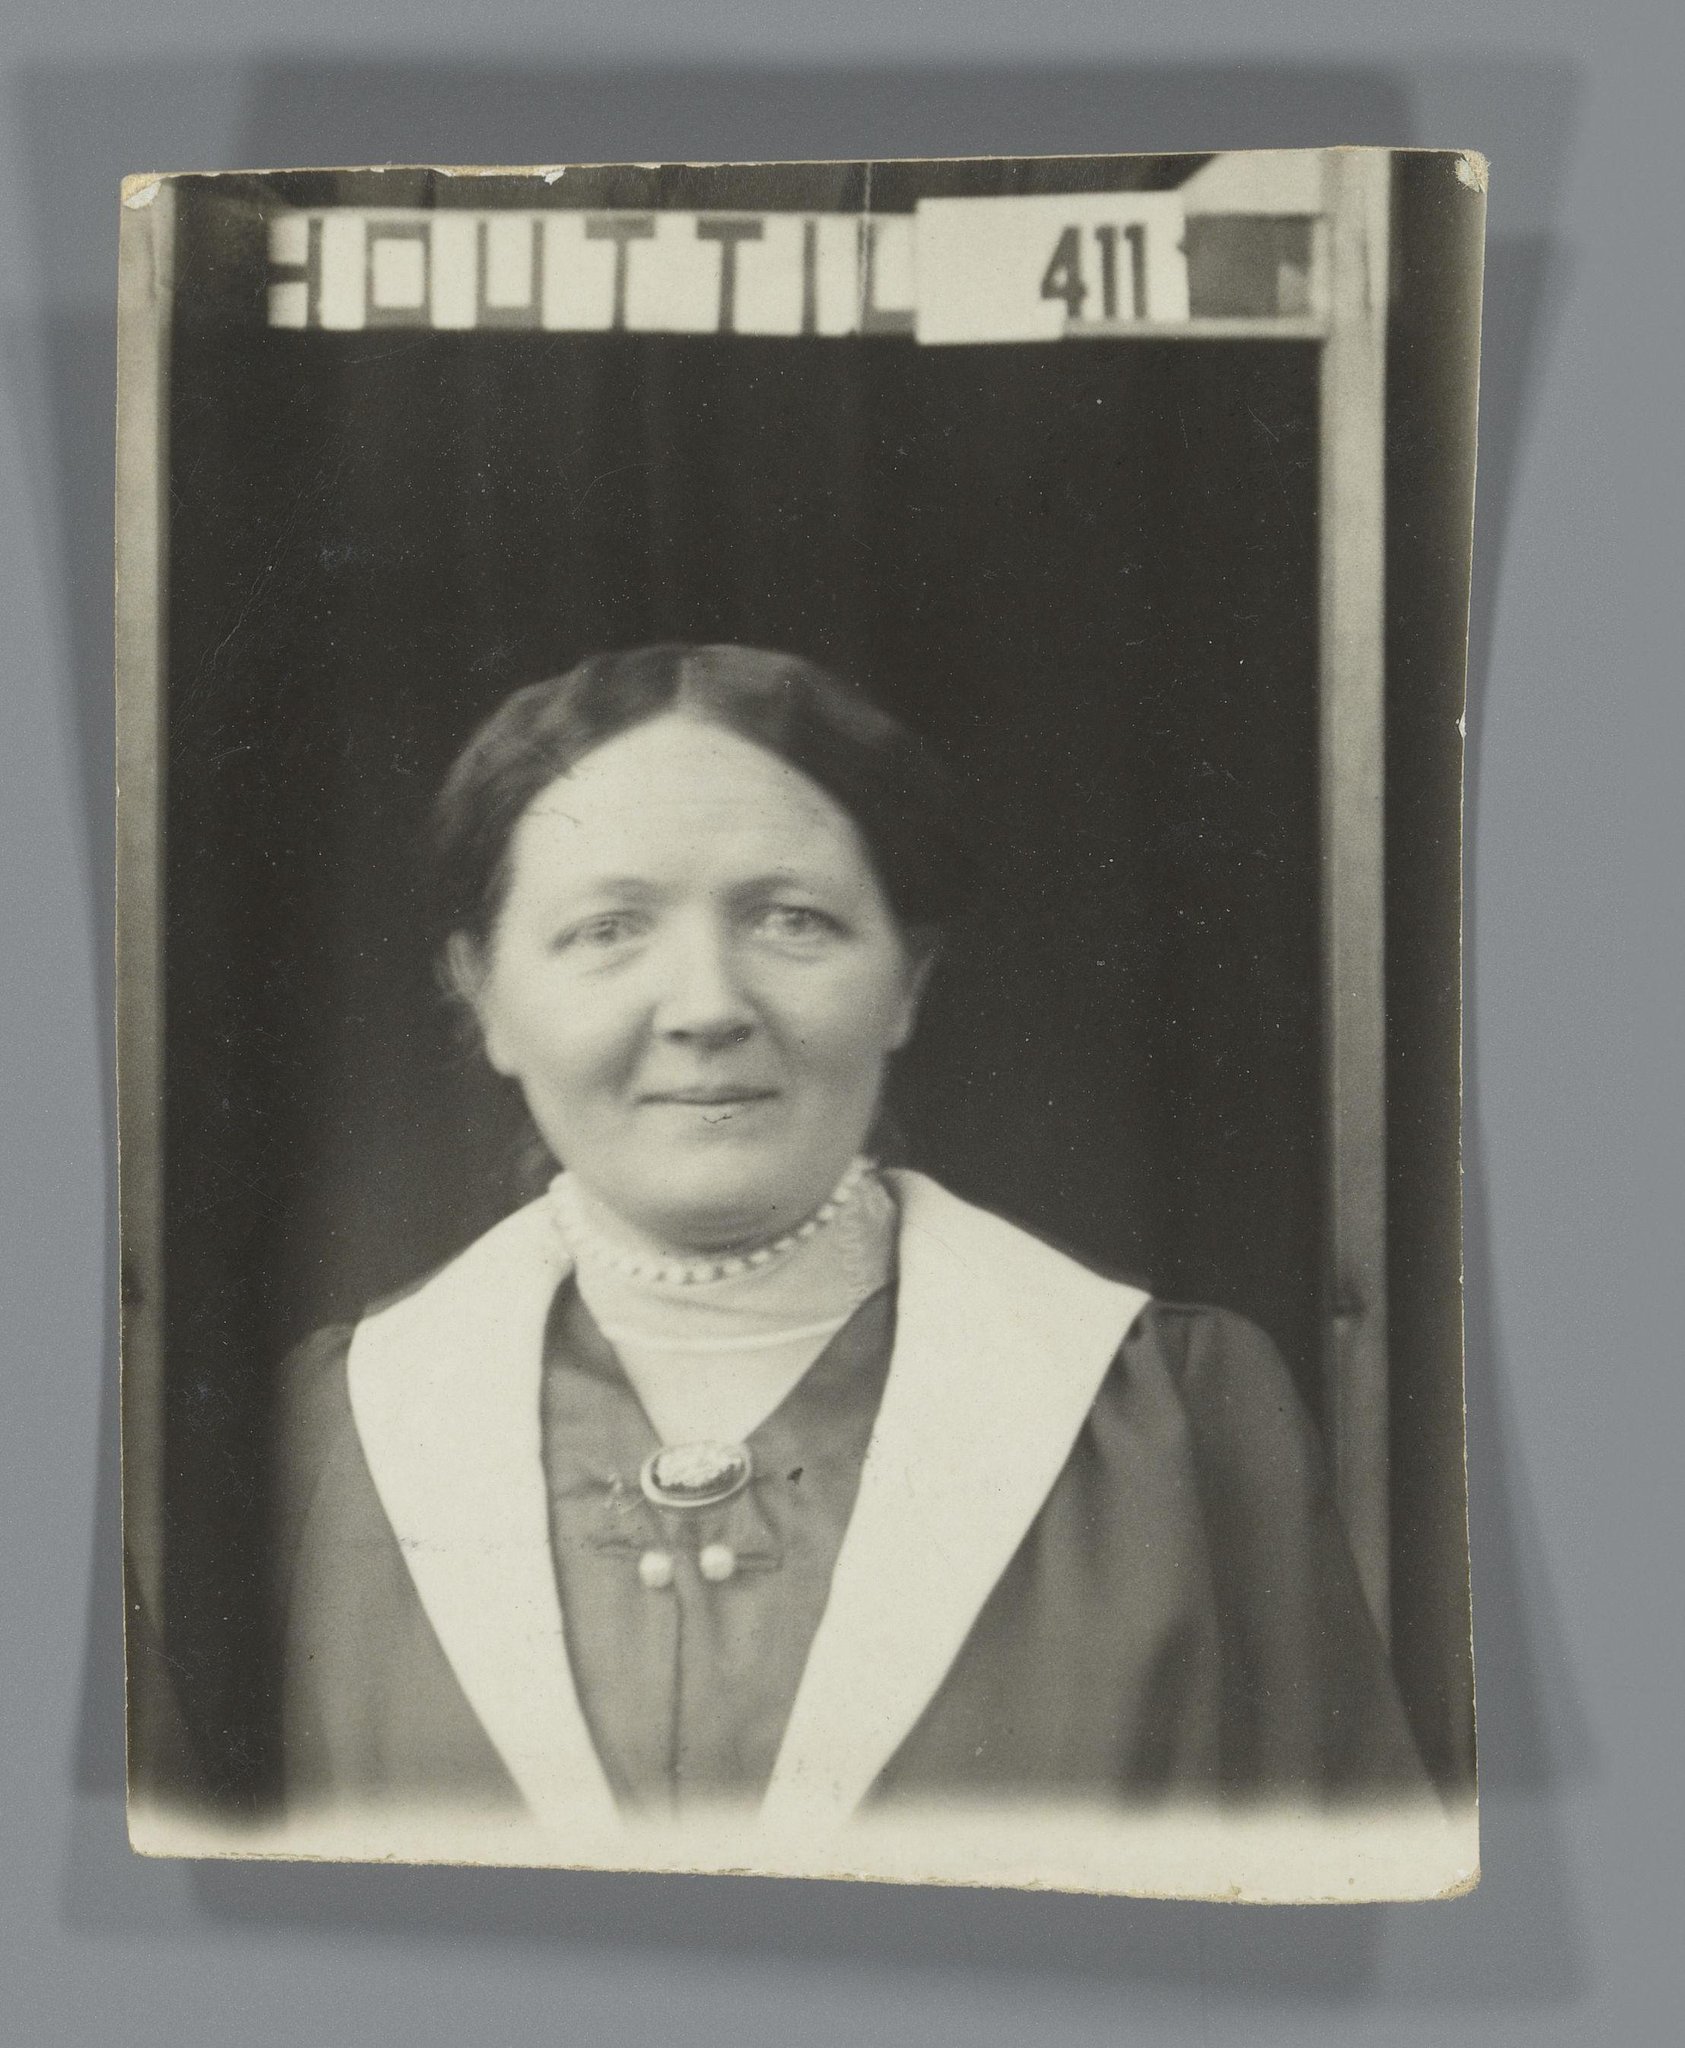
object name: snapshot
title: Rapid photographs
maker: jan gottfried stütner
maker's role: fotograaf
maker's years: 1892-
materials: photographic support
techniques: gelatin silver print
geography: alkmaar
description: Between 1912 and 1930, anyone could have their portrait taken at the many so-called rapid photography studios in the shopping streets of mainly (medium) large-size European cities. As if on an assembly line, the youngest clerk shot the photographs with a special camera and in artificial light and developed them. Later in the day, the customer collected a sheet with 12 portrait photos for 25 cents. This form of photographic mass production gave rise to a fascinating tableau of boys, girls, men and women not previously seen in photographs; candid and informal. There were at least 150 quick-photo studios, from Alkmaar to Zutphen. Many called themselves ‘American,’ mistakenly as it turns out because hardly any examples from that country have been found.